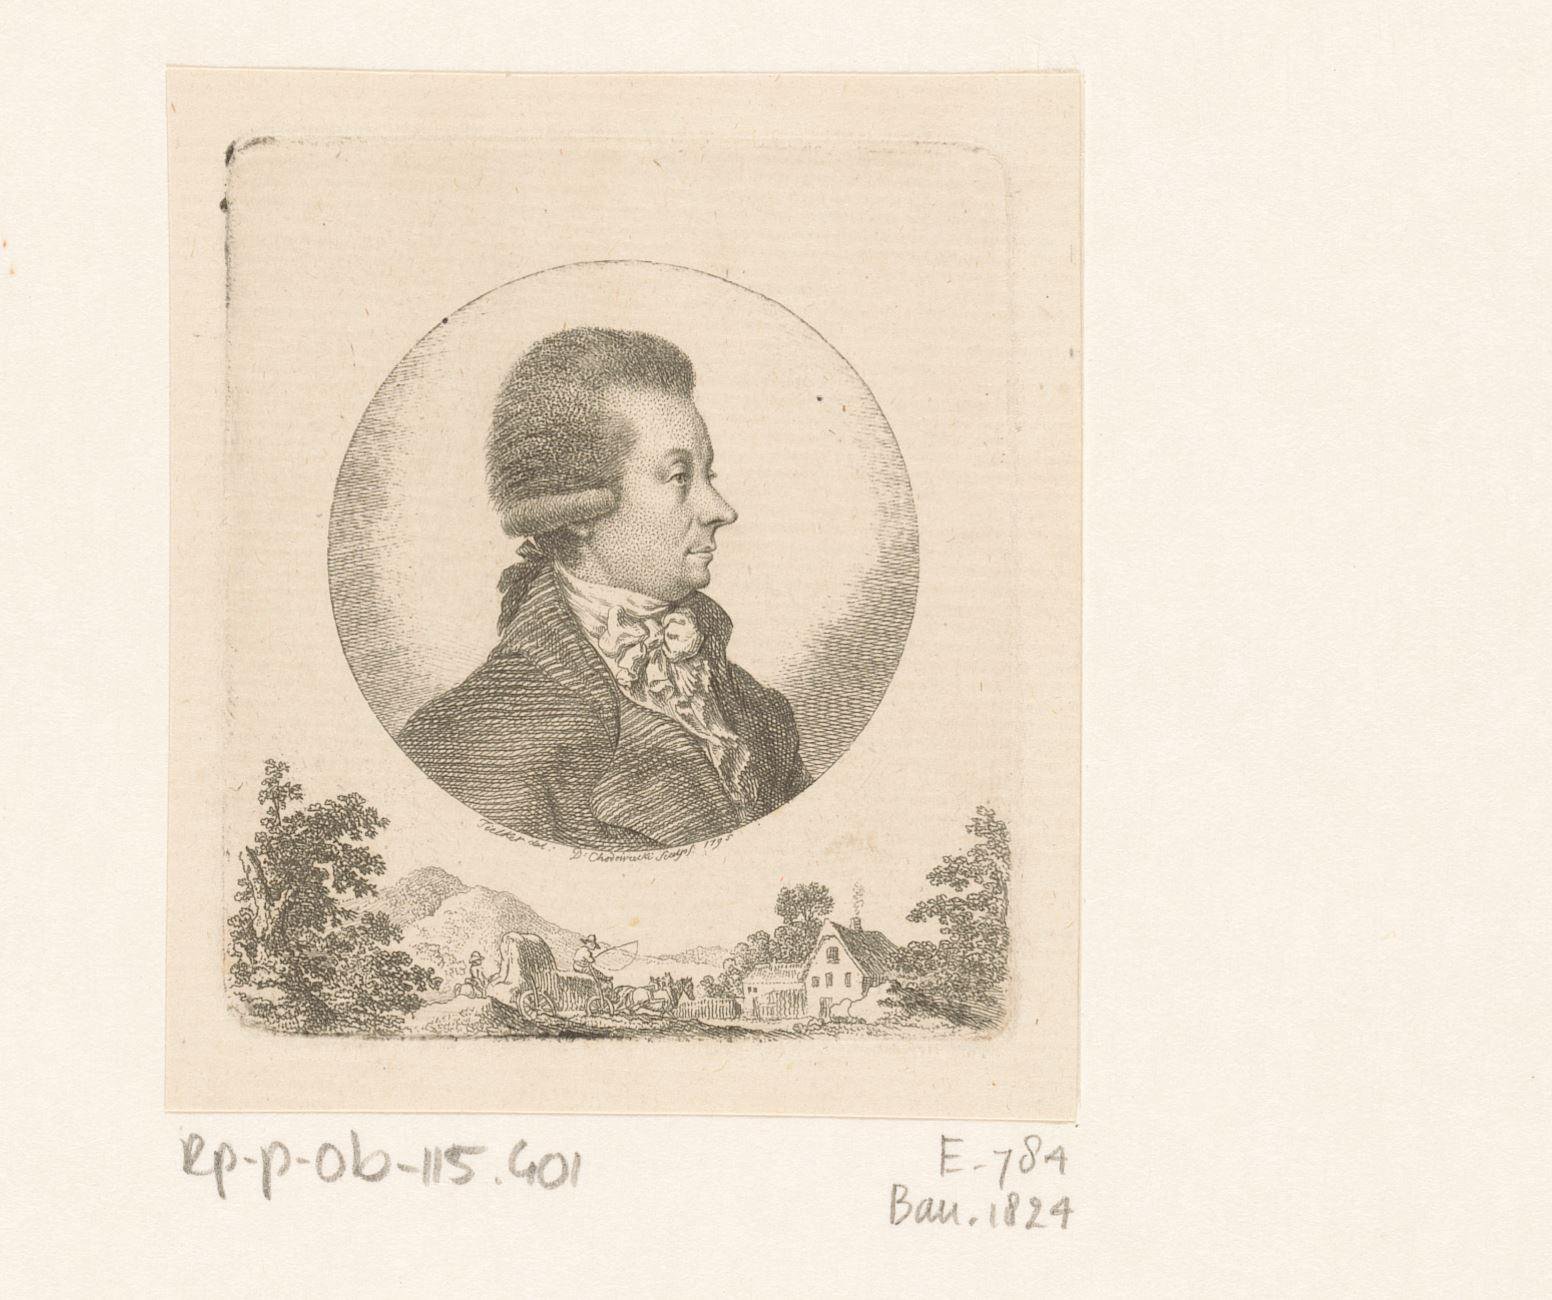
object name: print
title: Portret van Ludwig Höpfner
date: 1795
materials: paper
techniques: etching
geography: berlin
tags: landscapes, historical persons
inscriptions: collector's mark: Lugt 2228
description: In de marge is op schetsmatige wijze een landschap met figuren geëtst.